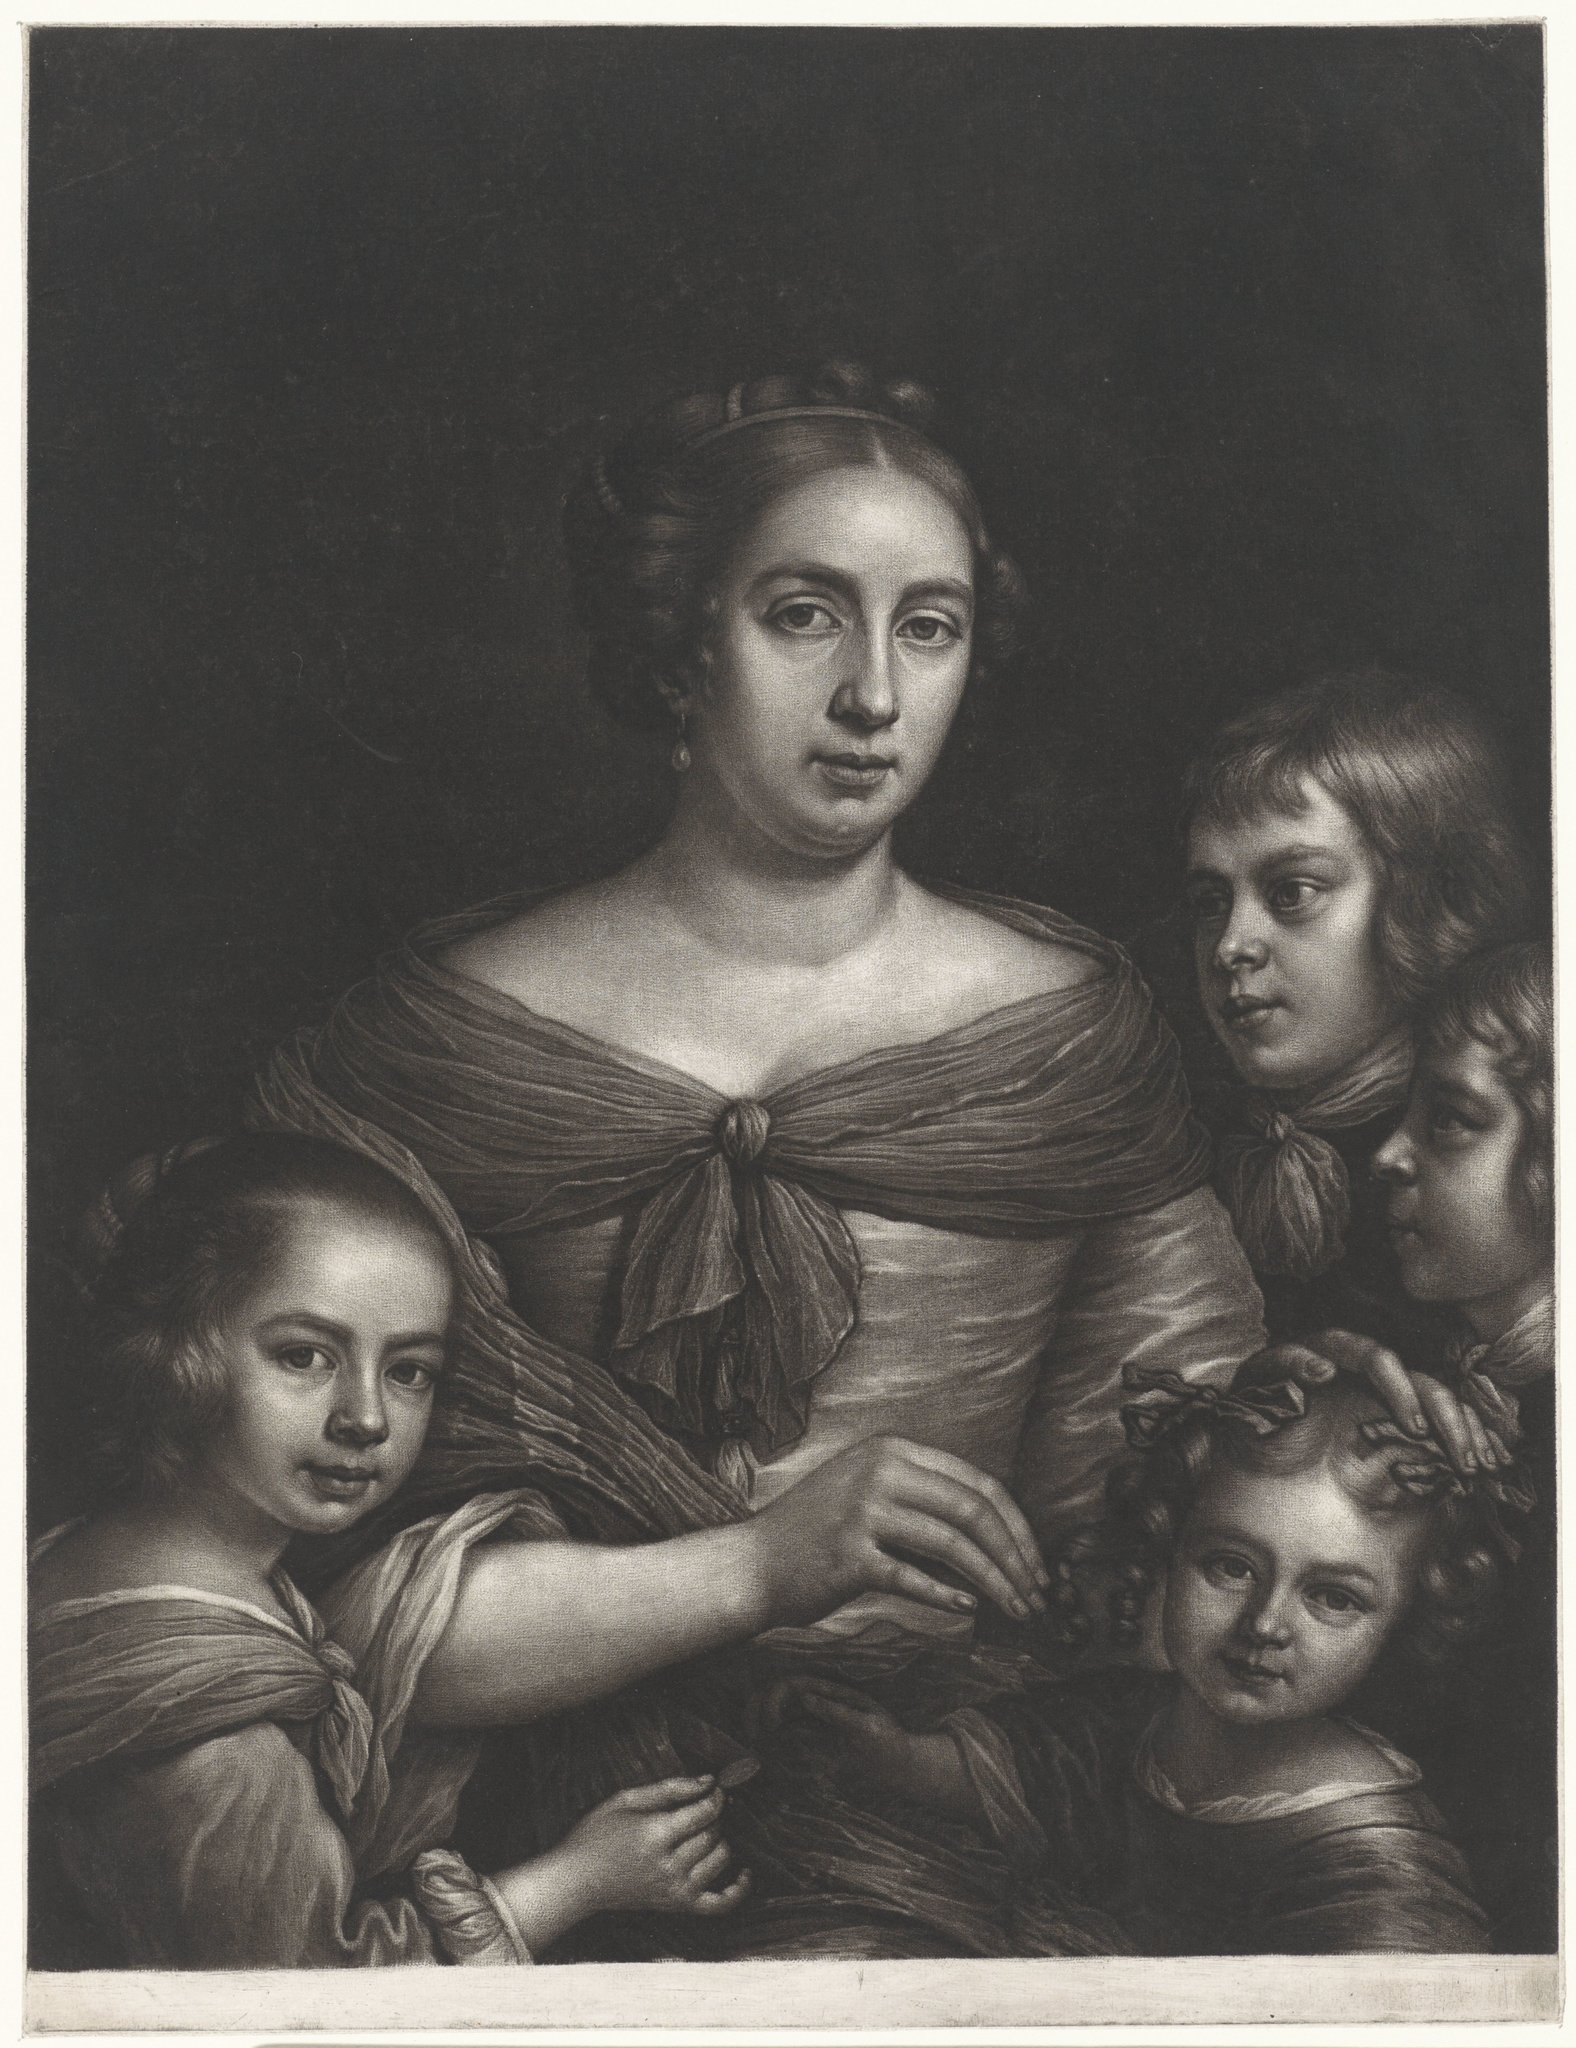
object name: print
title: Portret van een moeder met vier kinderen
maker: wallerant vaillant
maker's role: draughtsman, painter, print maker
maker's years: 1623-1677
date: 1658-1677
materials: paper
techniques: mezzotint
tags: mother and baby or young child, mother and child(ren), woman and child(ren) (family group), necklace (+ women's clothes)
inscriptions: collector's mark: Lugt 2228